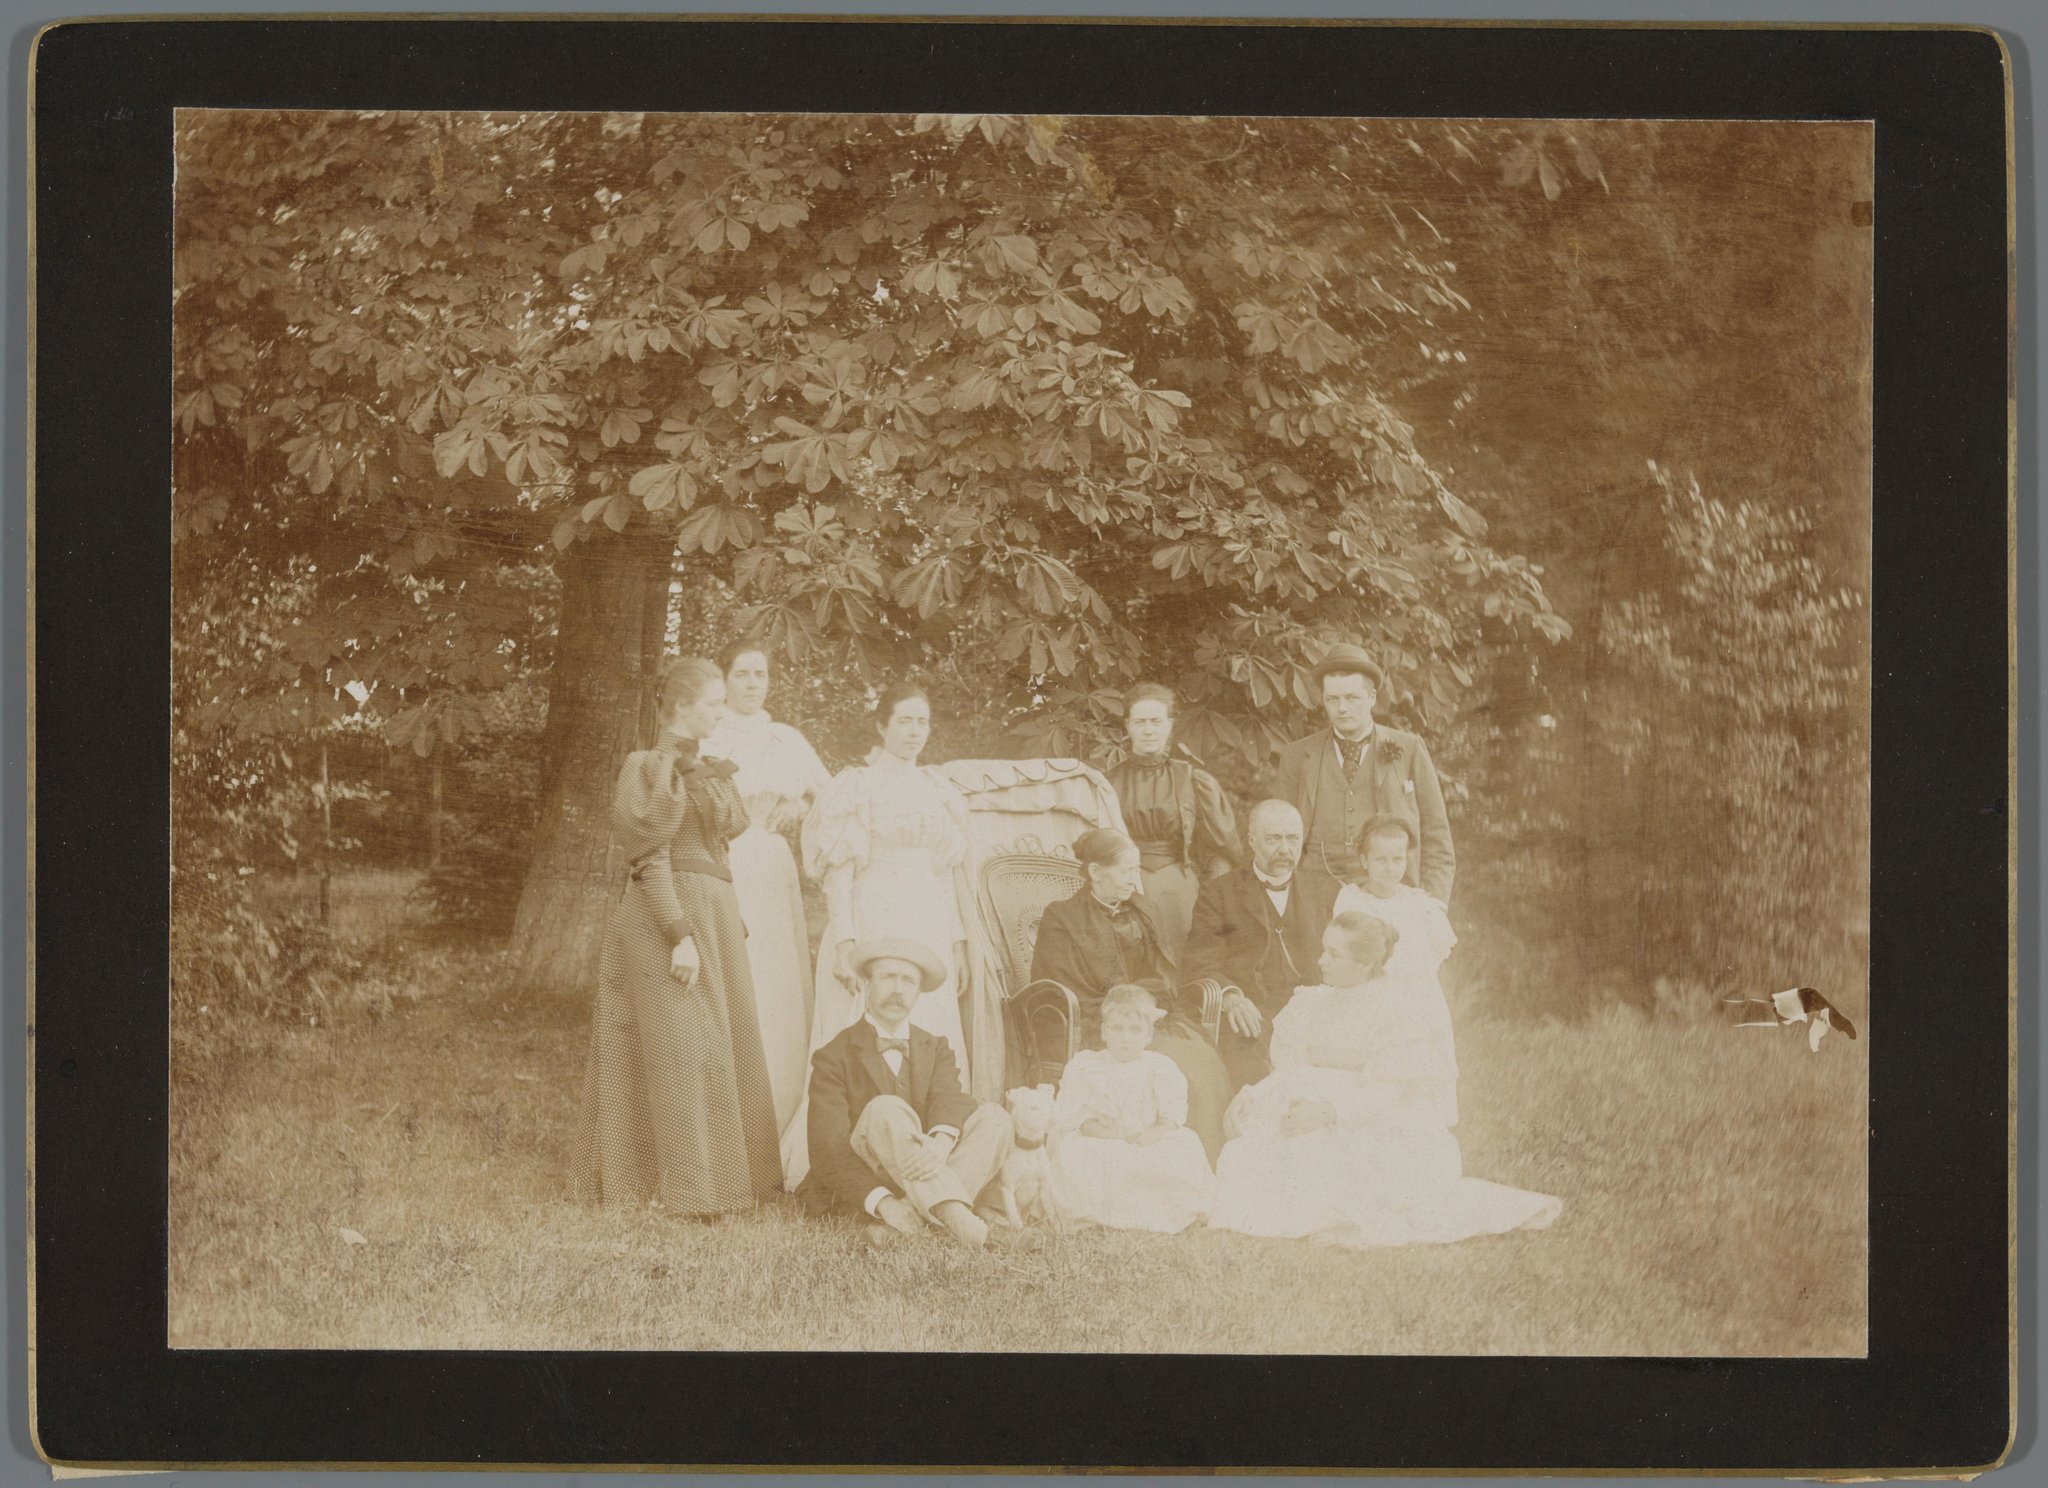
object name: photograph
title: Groepsportret van familie Jonker en Jonker Nije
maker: cornelia hendrika jonker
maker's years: 1874-1924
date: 1896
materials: cardboard, photographic support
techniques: collodion silver print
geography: maartensdijk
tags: cornelia hendrika jonker, garden, anonymous historical persons portrayed in a group, in a group-portrait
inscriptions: annotation: ‘C.J. augustus '96/ J.D. van der Waals’